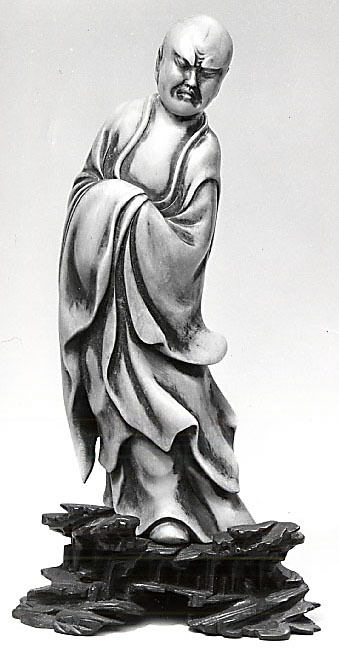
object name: statuette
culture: chinese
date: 1701-1800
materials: ivory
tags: men